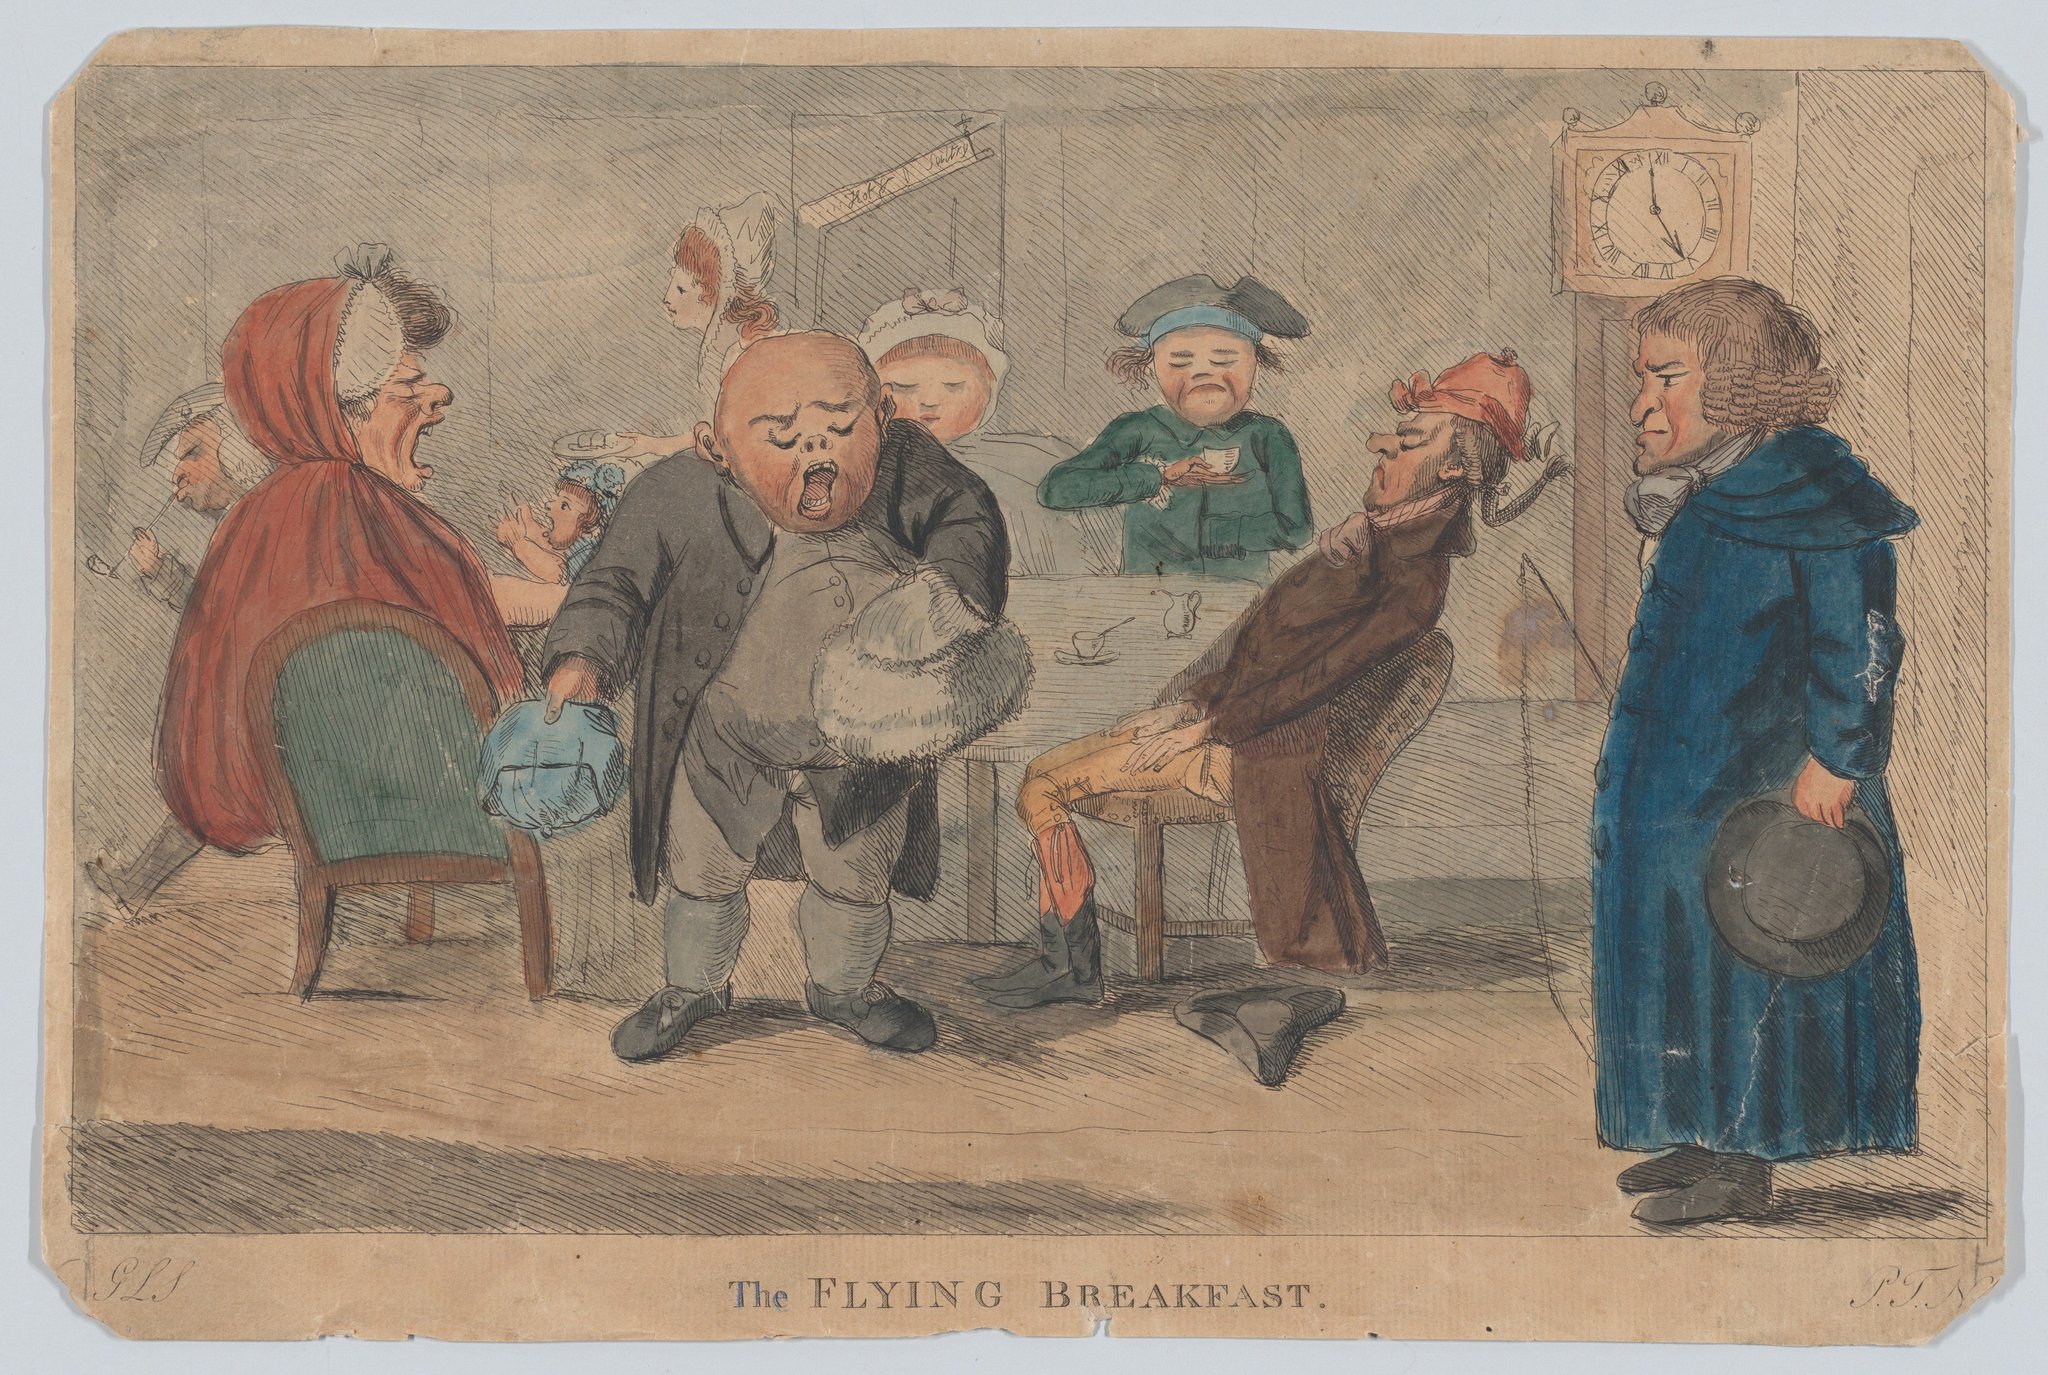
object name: print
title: The Flying Breakfast, or Contents of a Night Coach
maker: anonymous, british, 18th century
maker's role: etcher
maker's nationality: british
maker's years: 1700-1800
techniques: etching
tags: satire,men,women